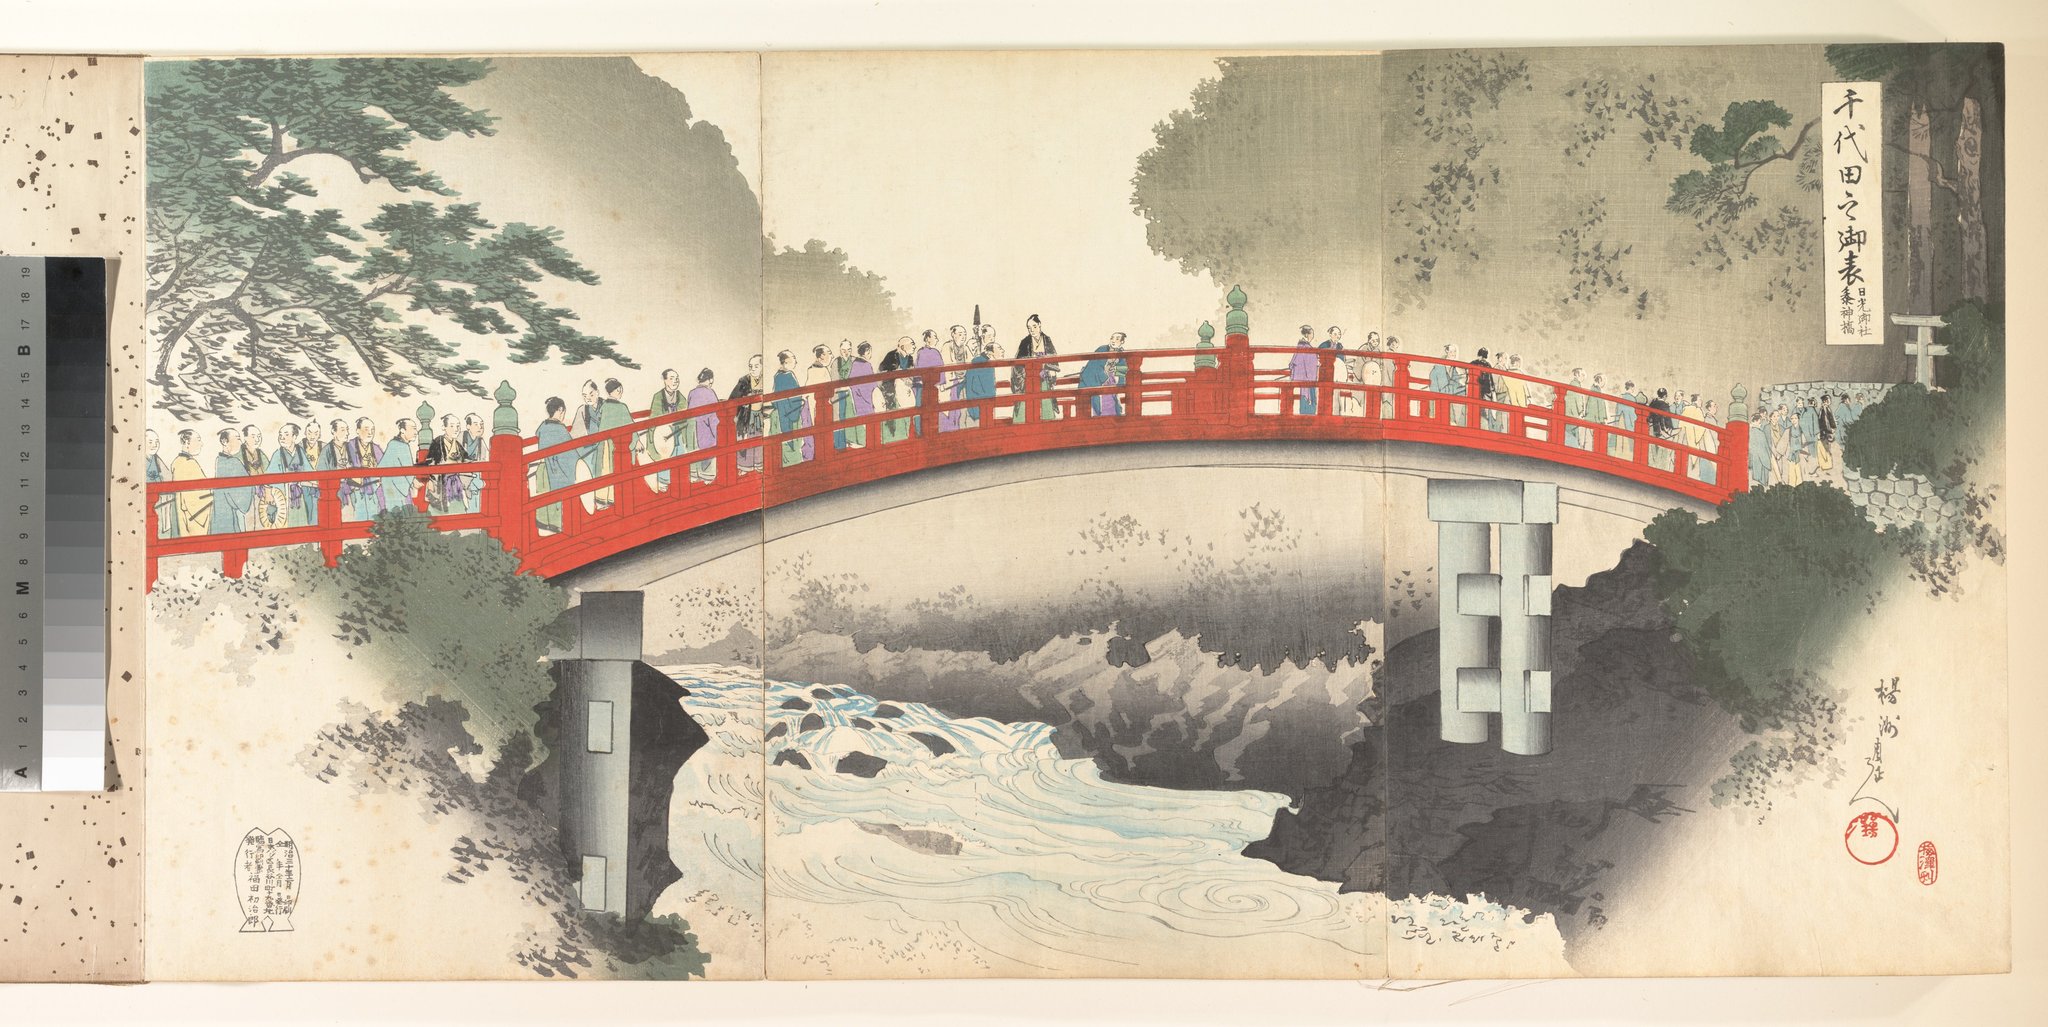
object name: print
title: Chiyoda Castle (Album of Men)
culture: japanese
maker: yōshū (hashimoto) chikanobu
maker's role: artist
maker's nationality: japanese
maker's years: 1838-1912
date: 1897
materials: ink, paper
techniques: woodblock print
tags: human figures,bridges,rivers